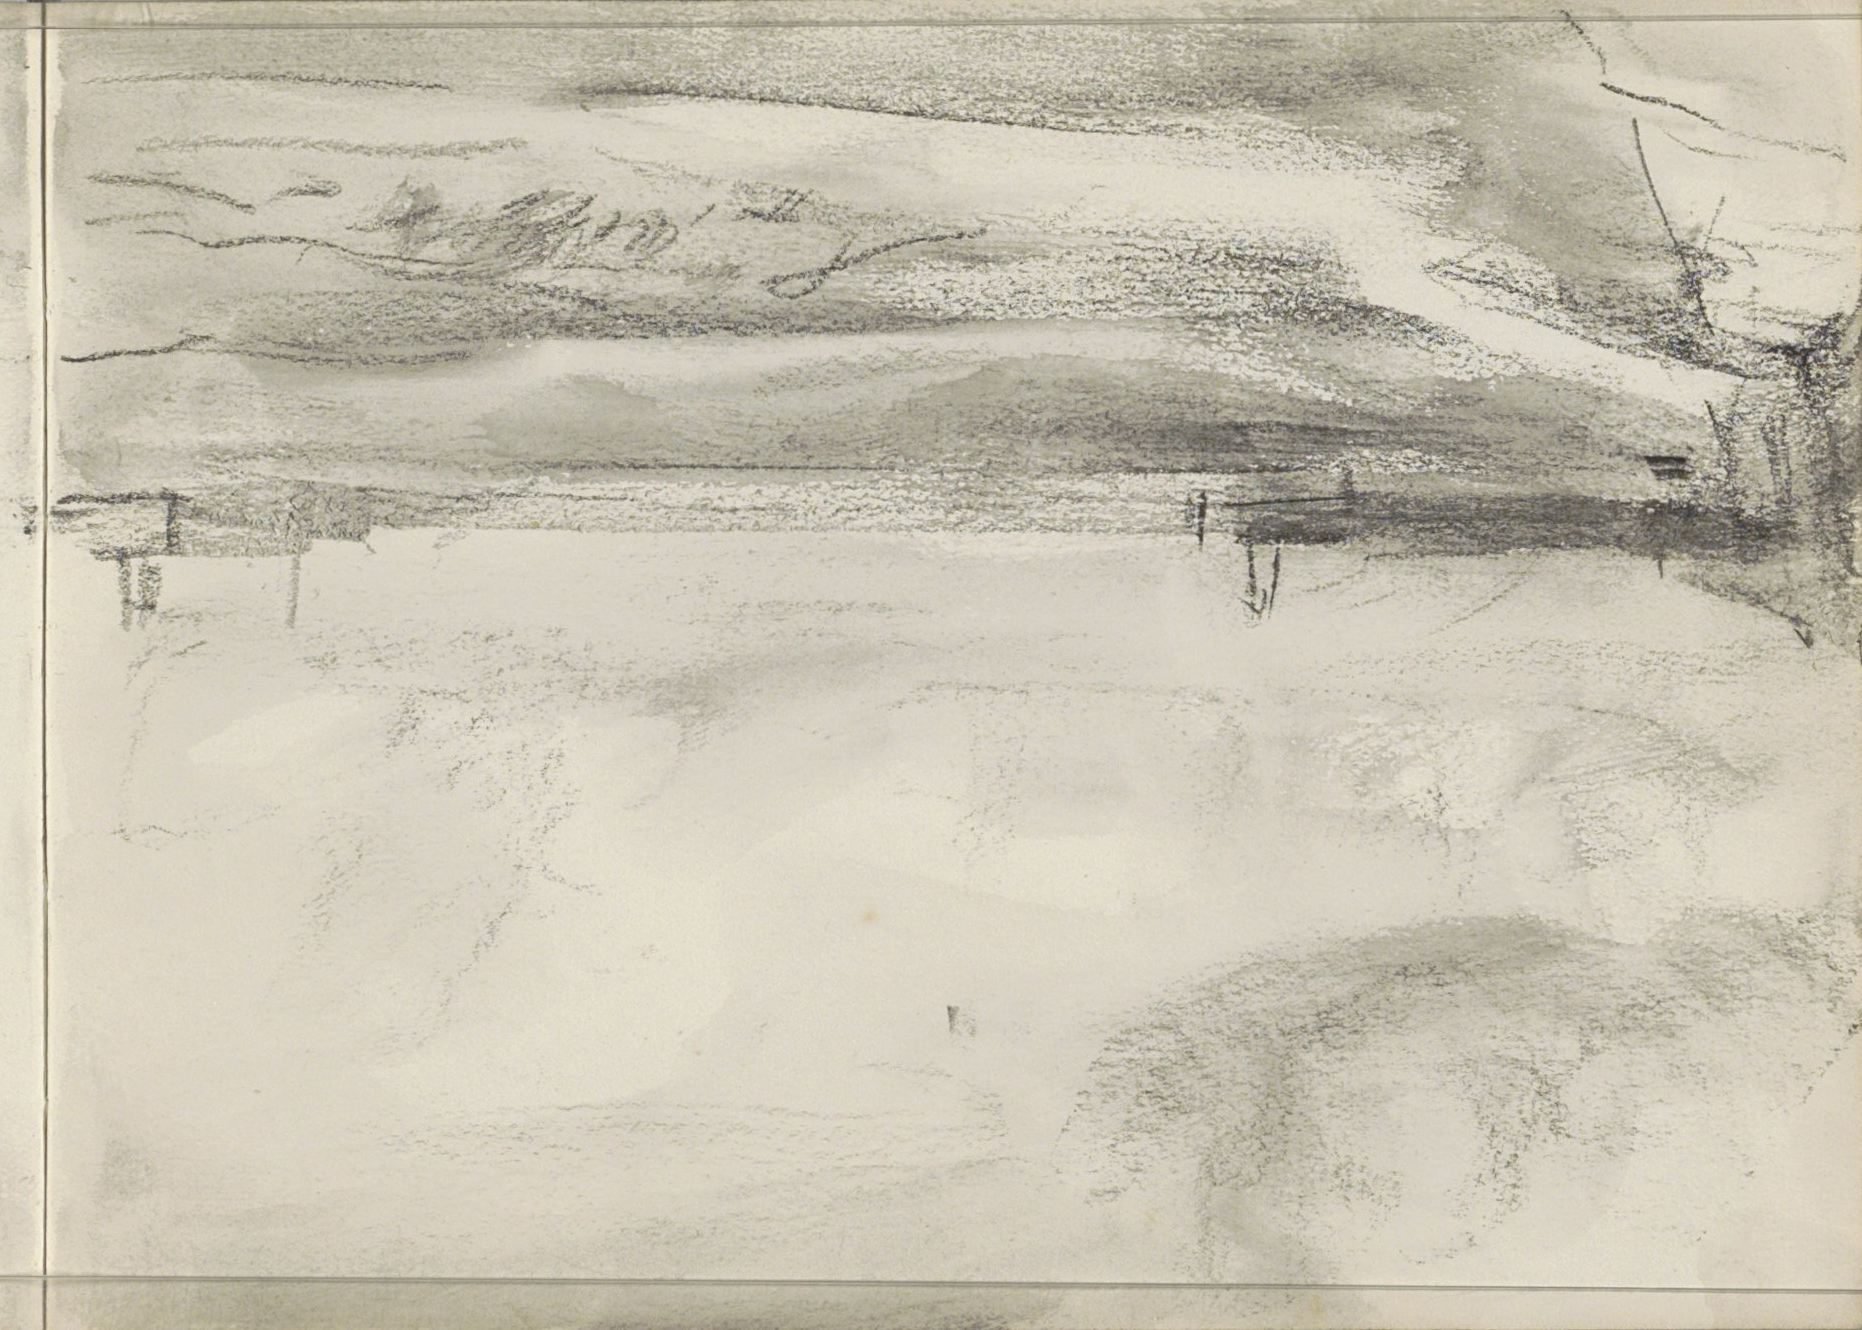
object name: sketchbook leaf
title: Kustgezicht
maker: johan antonie de jonge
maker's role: draughtsman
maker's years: 1864-1927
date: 1920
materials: chalk, paper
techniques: stumping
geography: south holland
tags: coast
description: Kustgezicht. Blad 7 recto uit een schetsboek met 21 bladen.